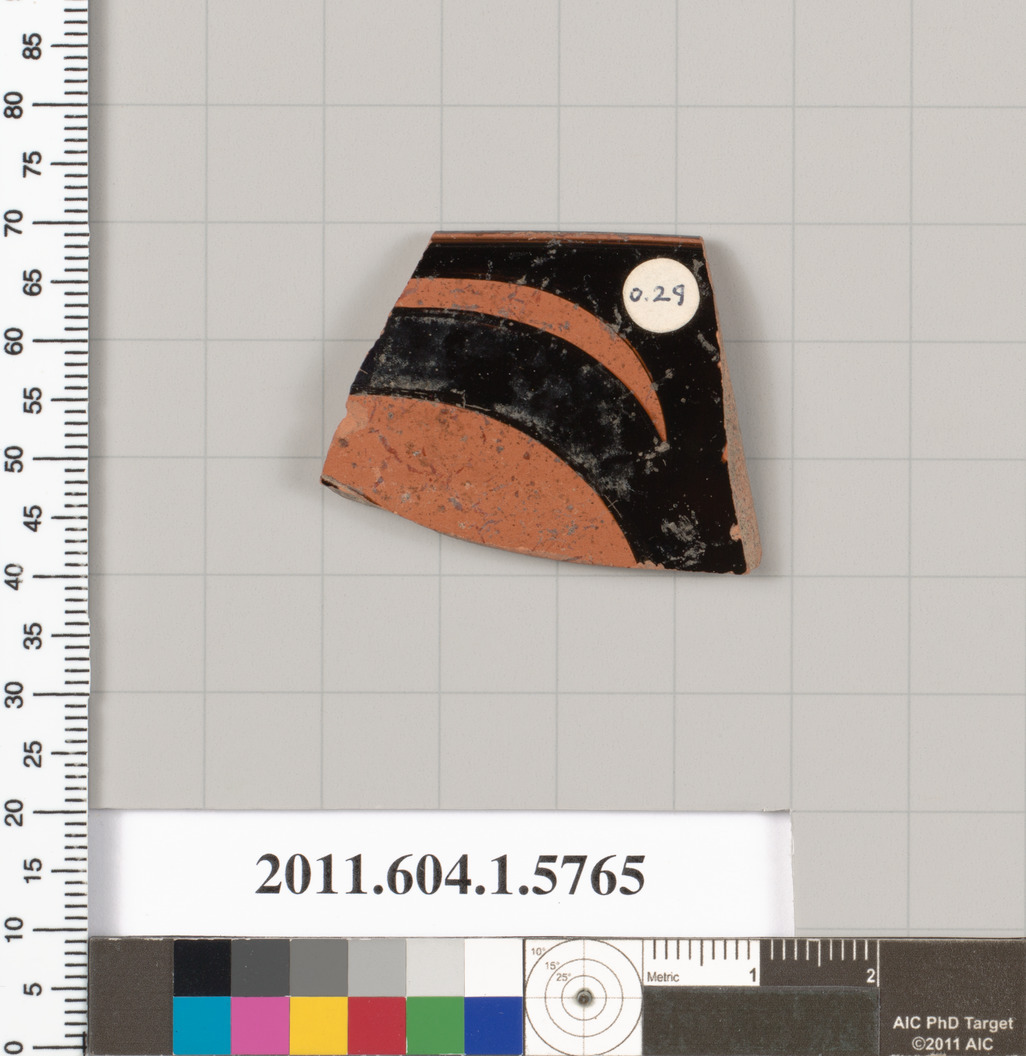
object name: kylix fragment, eye cup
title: Terracotta rim fragment of a kylix: eye-cup (drinking cup)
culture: greek, attic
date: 525-510 BCE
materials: terracotta